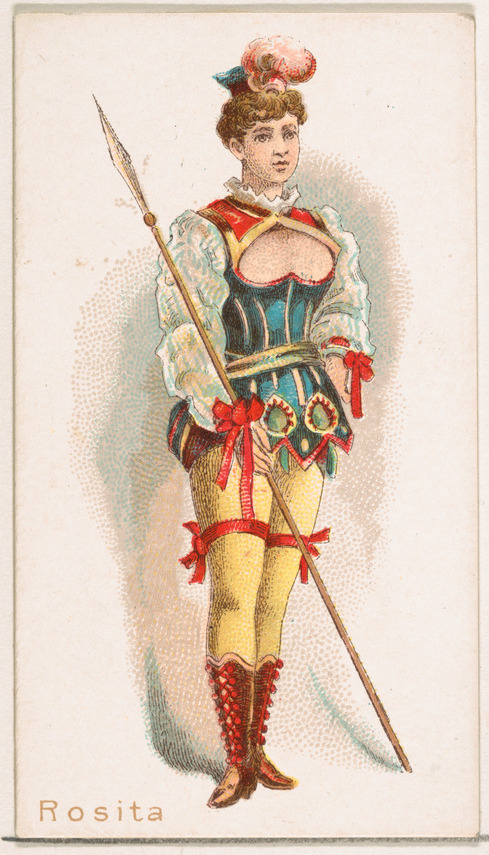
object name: print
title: Rosita, from the Ballet Queens series (N182) issued by Wm. S. Kimball & Co.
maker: william s. kimball & company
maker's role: publisher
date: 1889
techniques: color lithograph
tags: spears,women